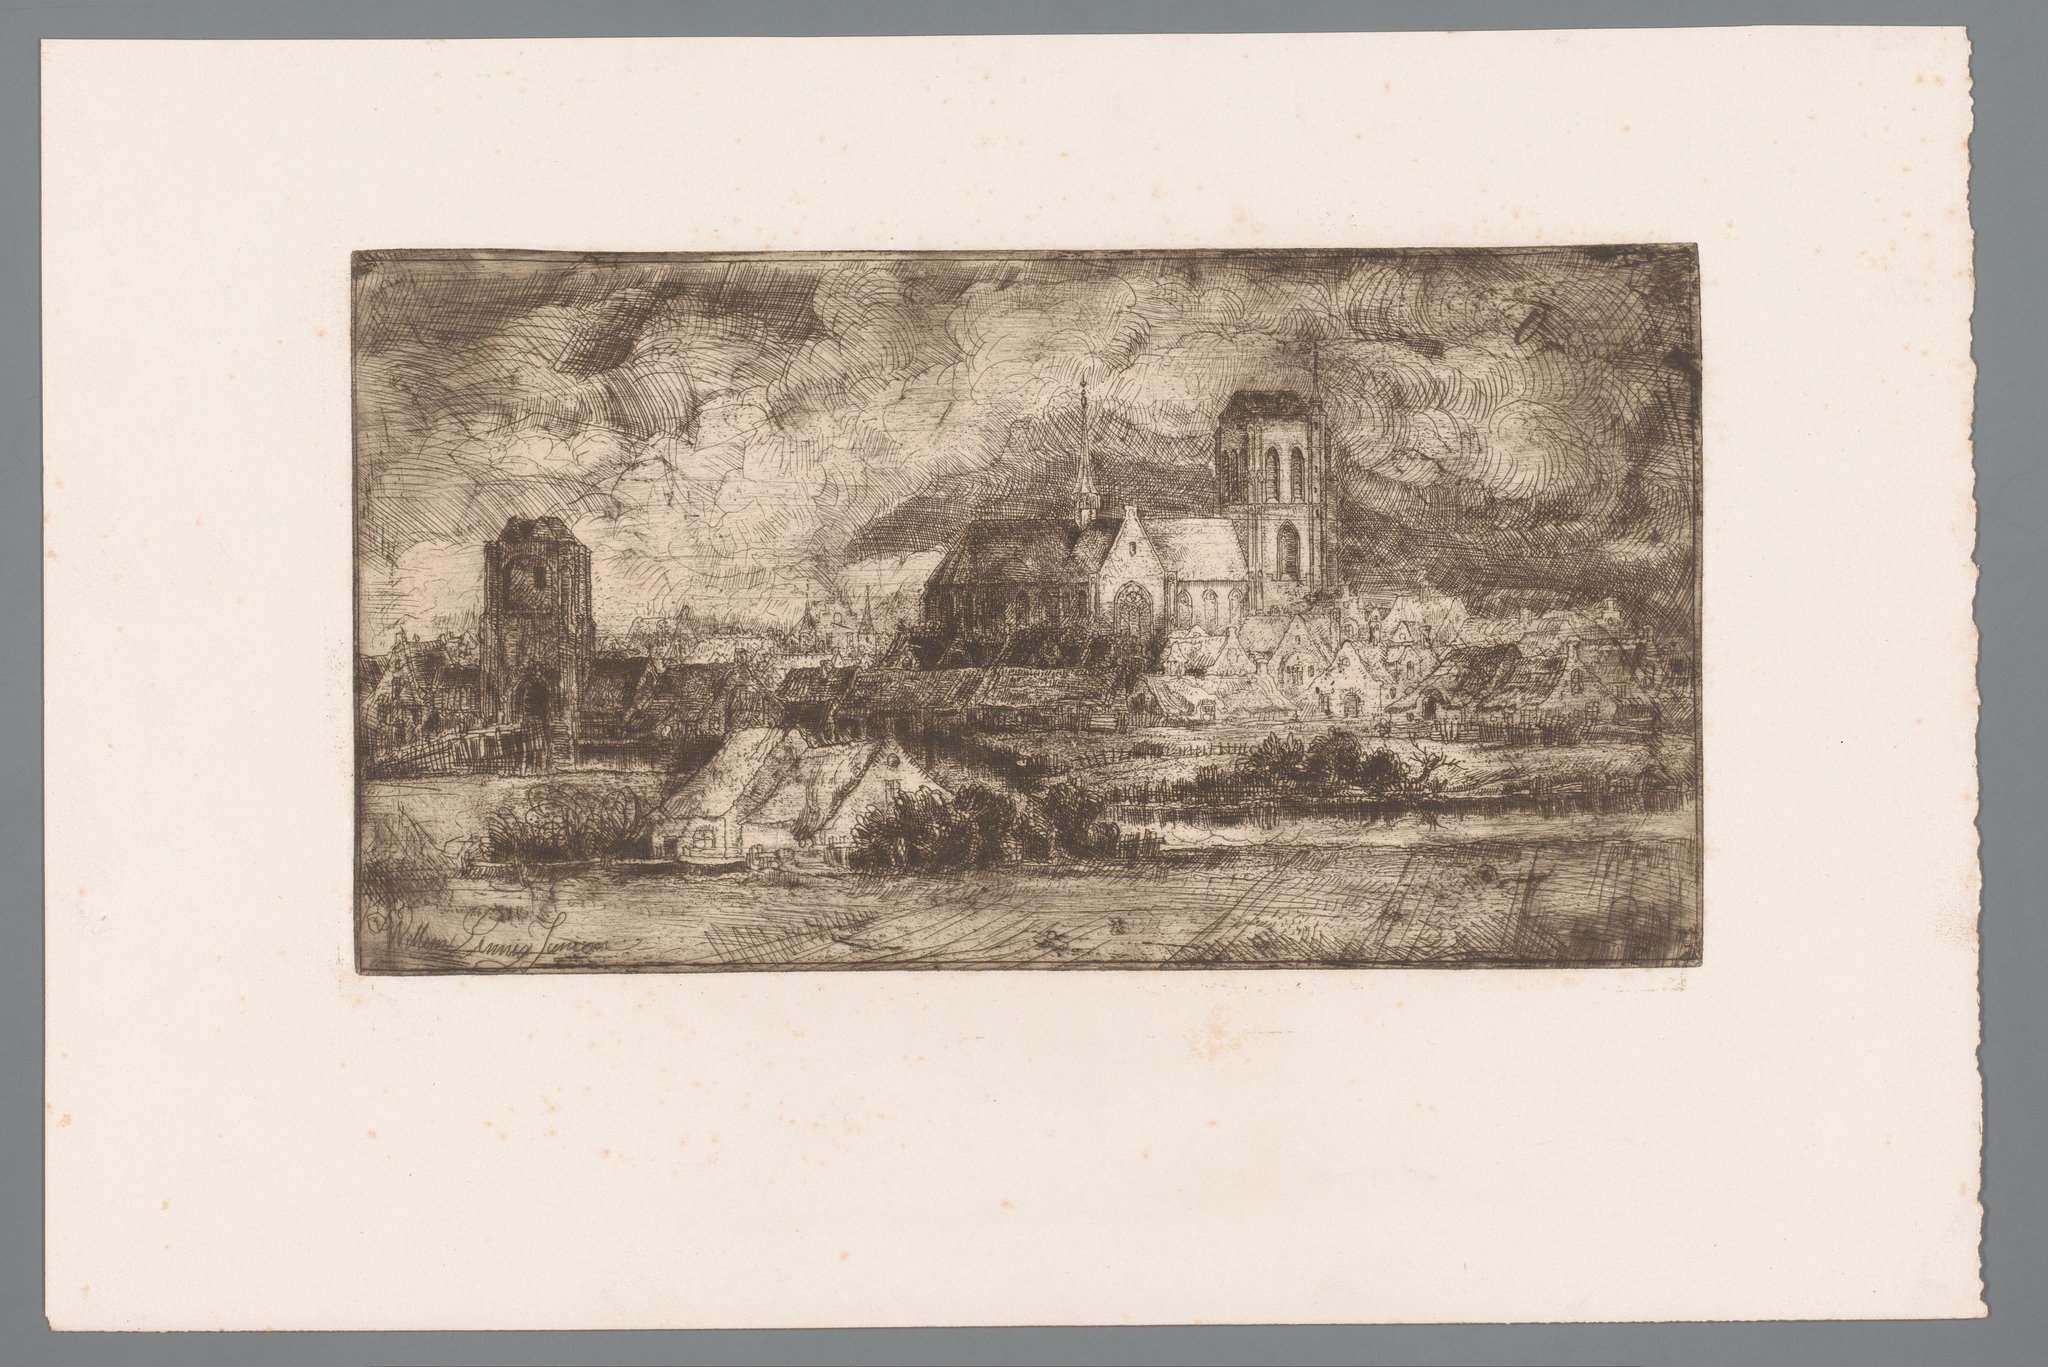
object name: print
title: Stadsgezicht met prominent kerkgebouw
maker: willem linnig (ii)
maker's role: print maker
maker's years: 1842-1890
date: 1876-1889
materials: paper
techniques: etching, intaglio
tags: city-view in general; 'veduta', church (exterior)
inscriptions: collector's mark: Lugt 2228